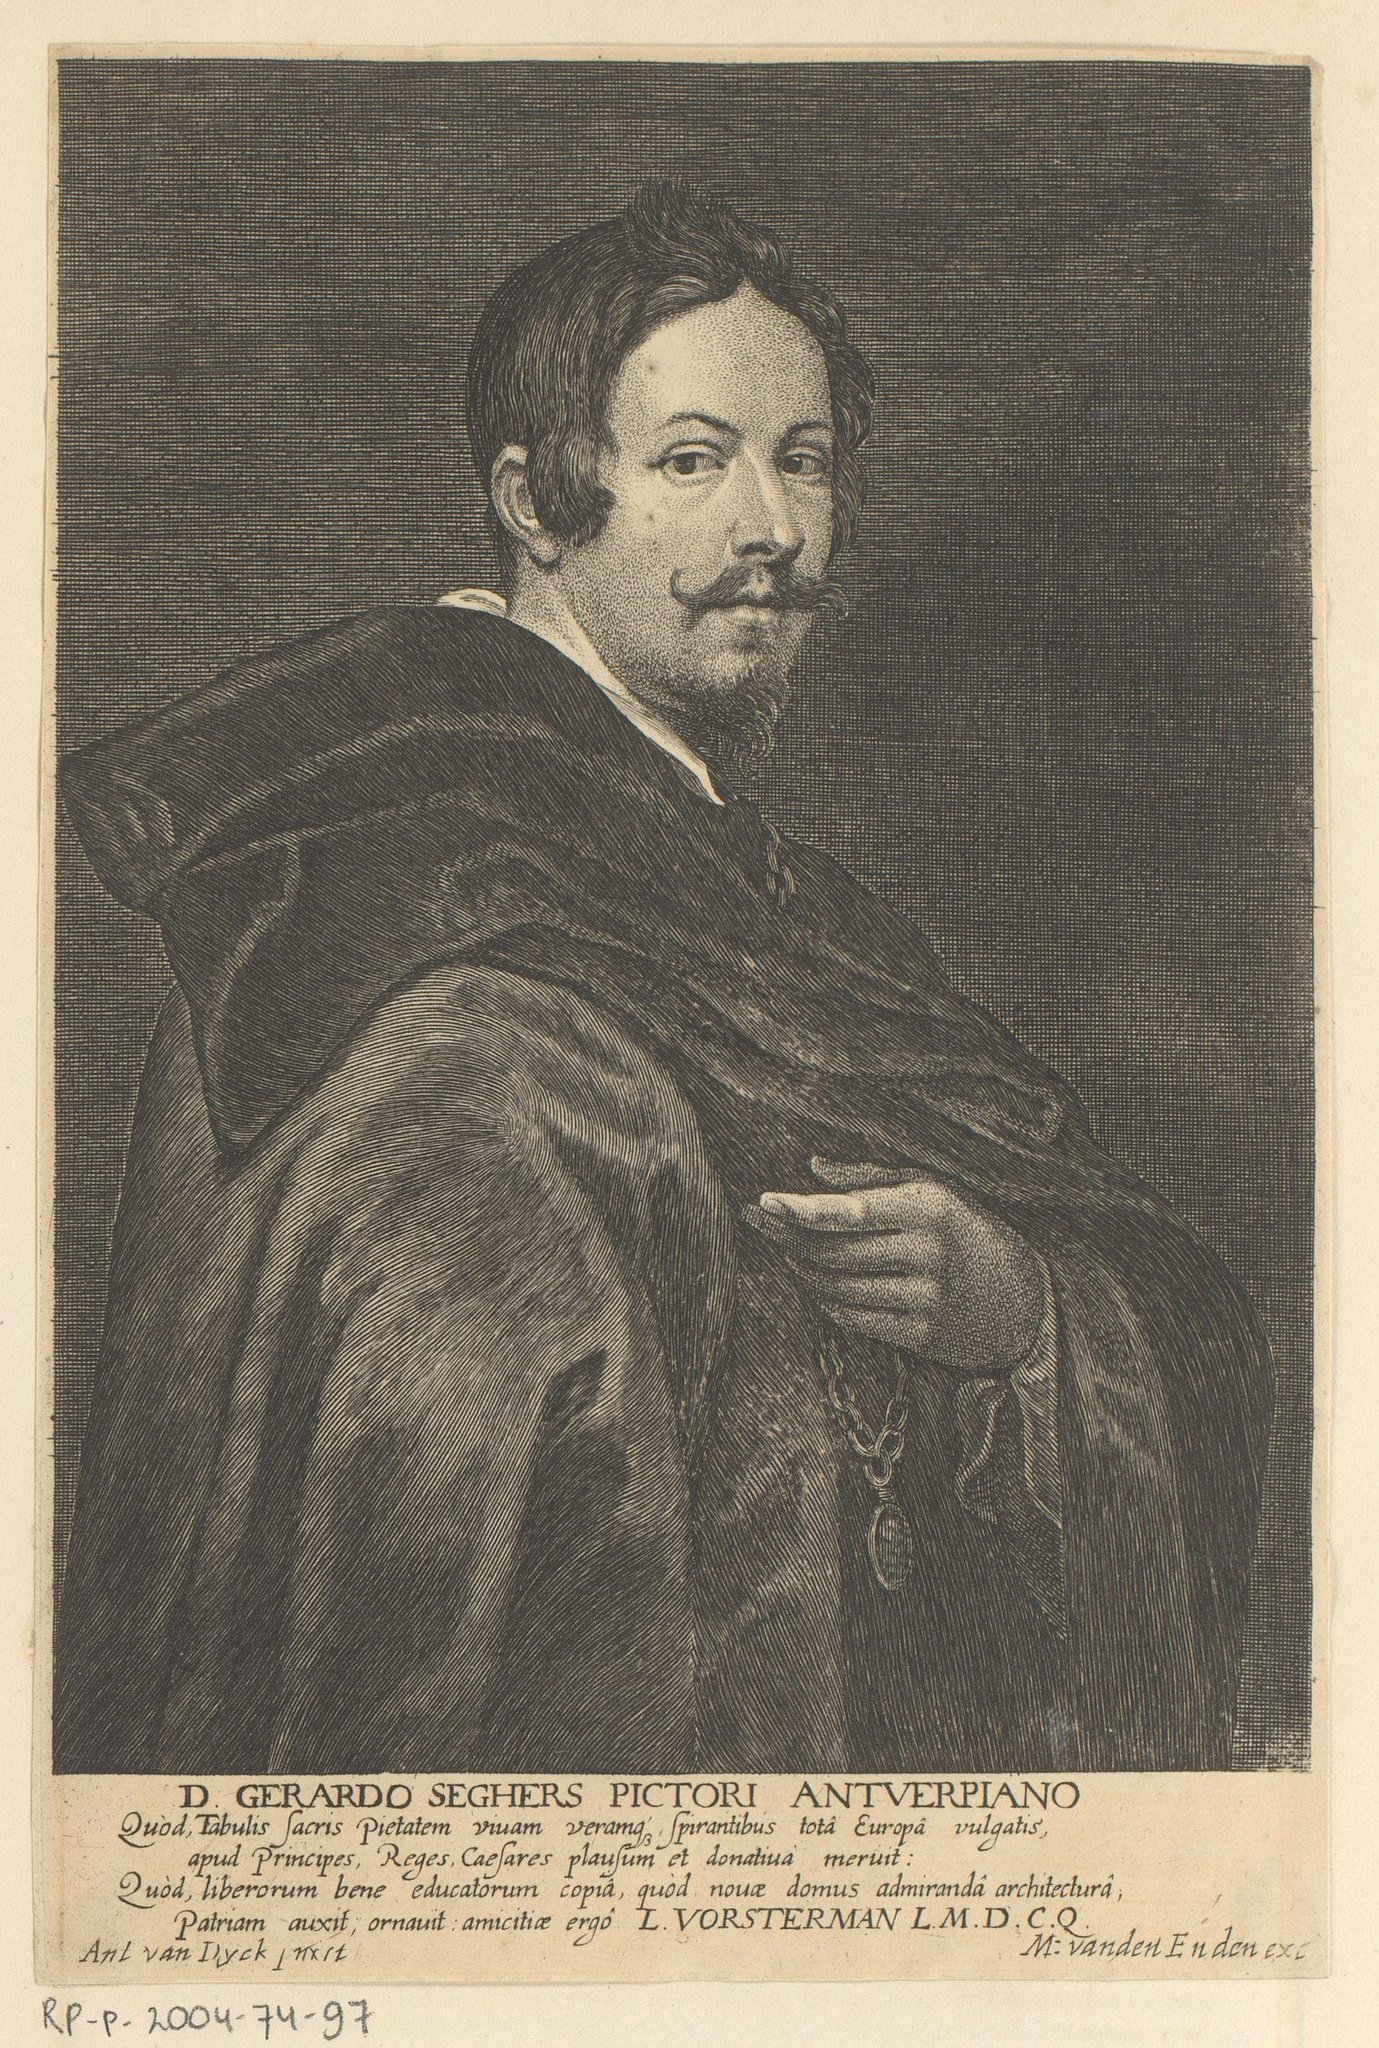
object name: album leaf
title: Portret van Gerard Seghers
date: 1630-1658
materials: paper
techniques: engraving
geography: antwerp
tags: antwerp, painter, print maker, gerard seghers, historical persons, portrait, self-portrait of painter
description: De samensteller heeft deze prent in het album geplakt als illustratie bij: Pilkington, Matthew en Johann Heinrich Füssli. A dictionary of painters, from the revival of the art to the present period. 4 dln. Londen: John Crowder, 1805, dl. 3, p. 512.